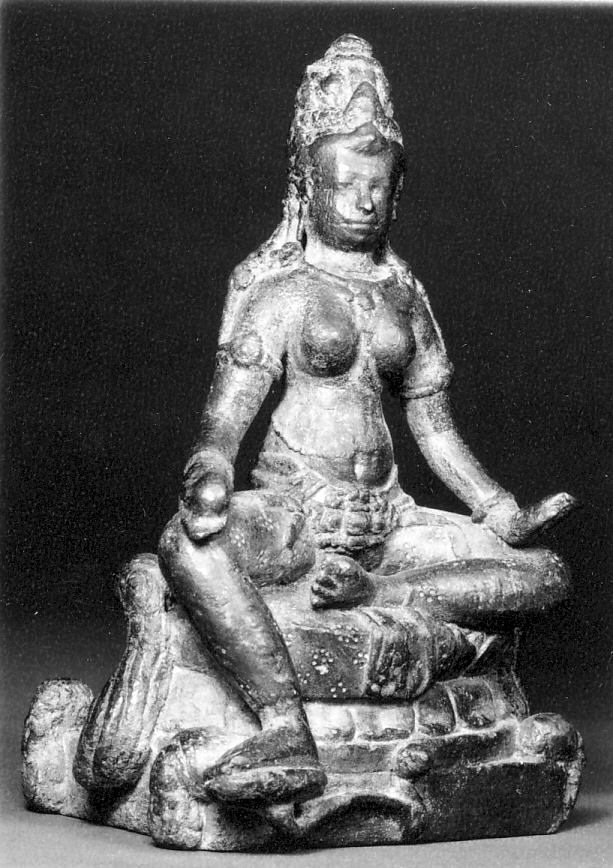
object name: figure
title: Seated River Goddess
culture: indonesian, javanese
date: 801-900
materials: bronze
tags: goddess